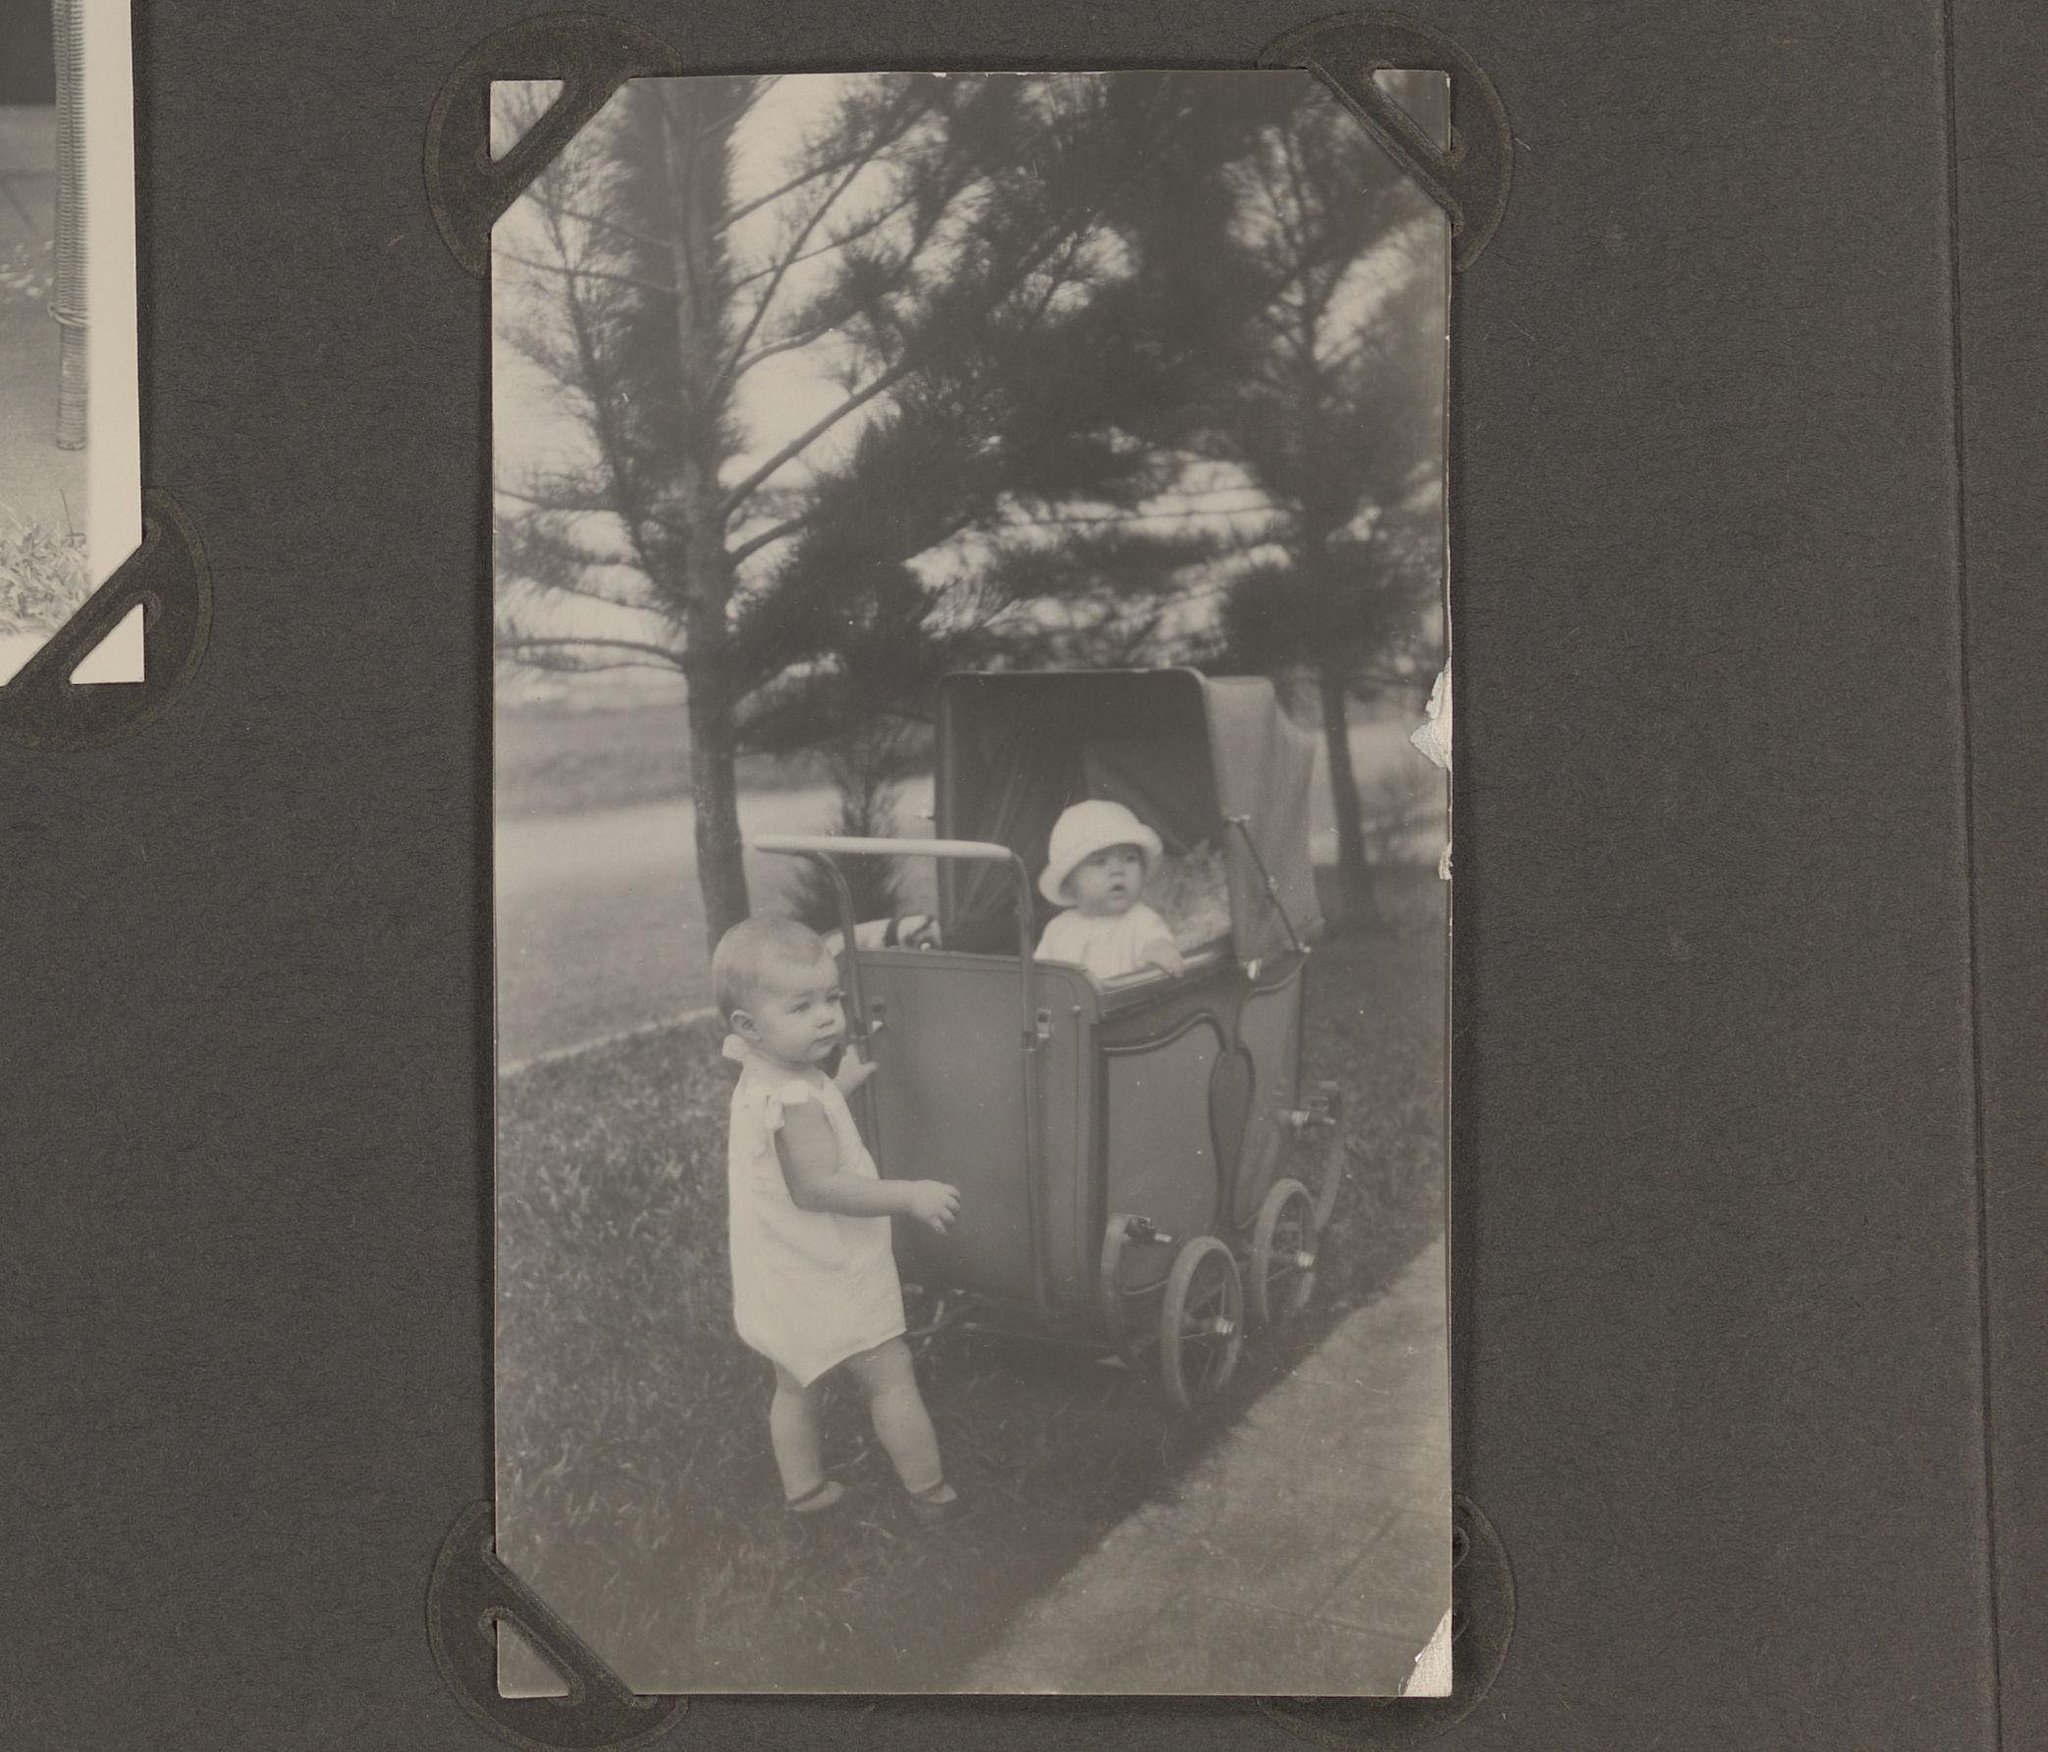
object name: photograph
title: Familiefoto van de kinderen Jetten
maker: Anonymous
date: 1925-1927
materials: photographic support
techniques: photography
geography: suriname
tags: jetten, familie, moengo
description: Familiefoto van de kinderen Jetten. Foto op een bladzijde van een los albumblad. Onderdeel van het ensemble met foto's van de familie van ingenieur Jetten in de mijnbouwstad Moengo in Suriname.